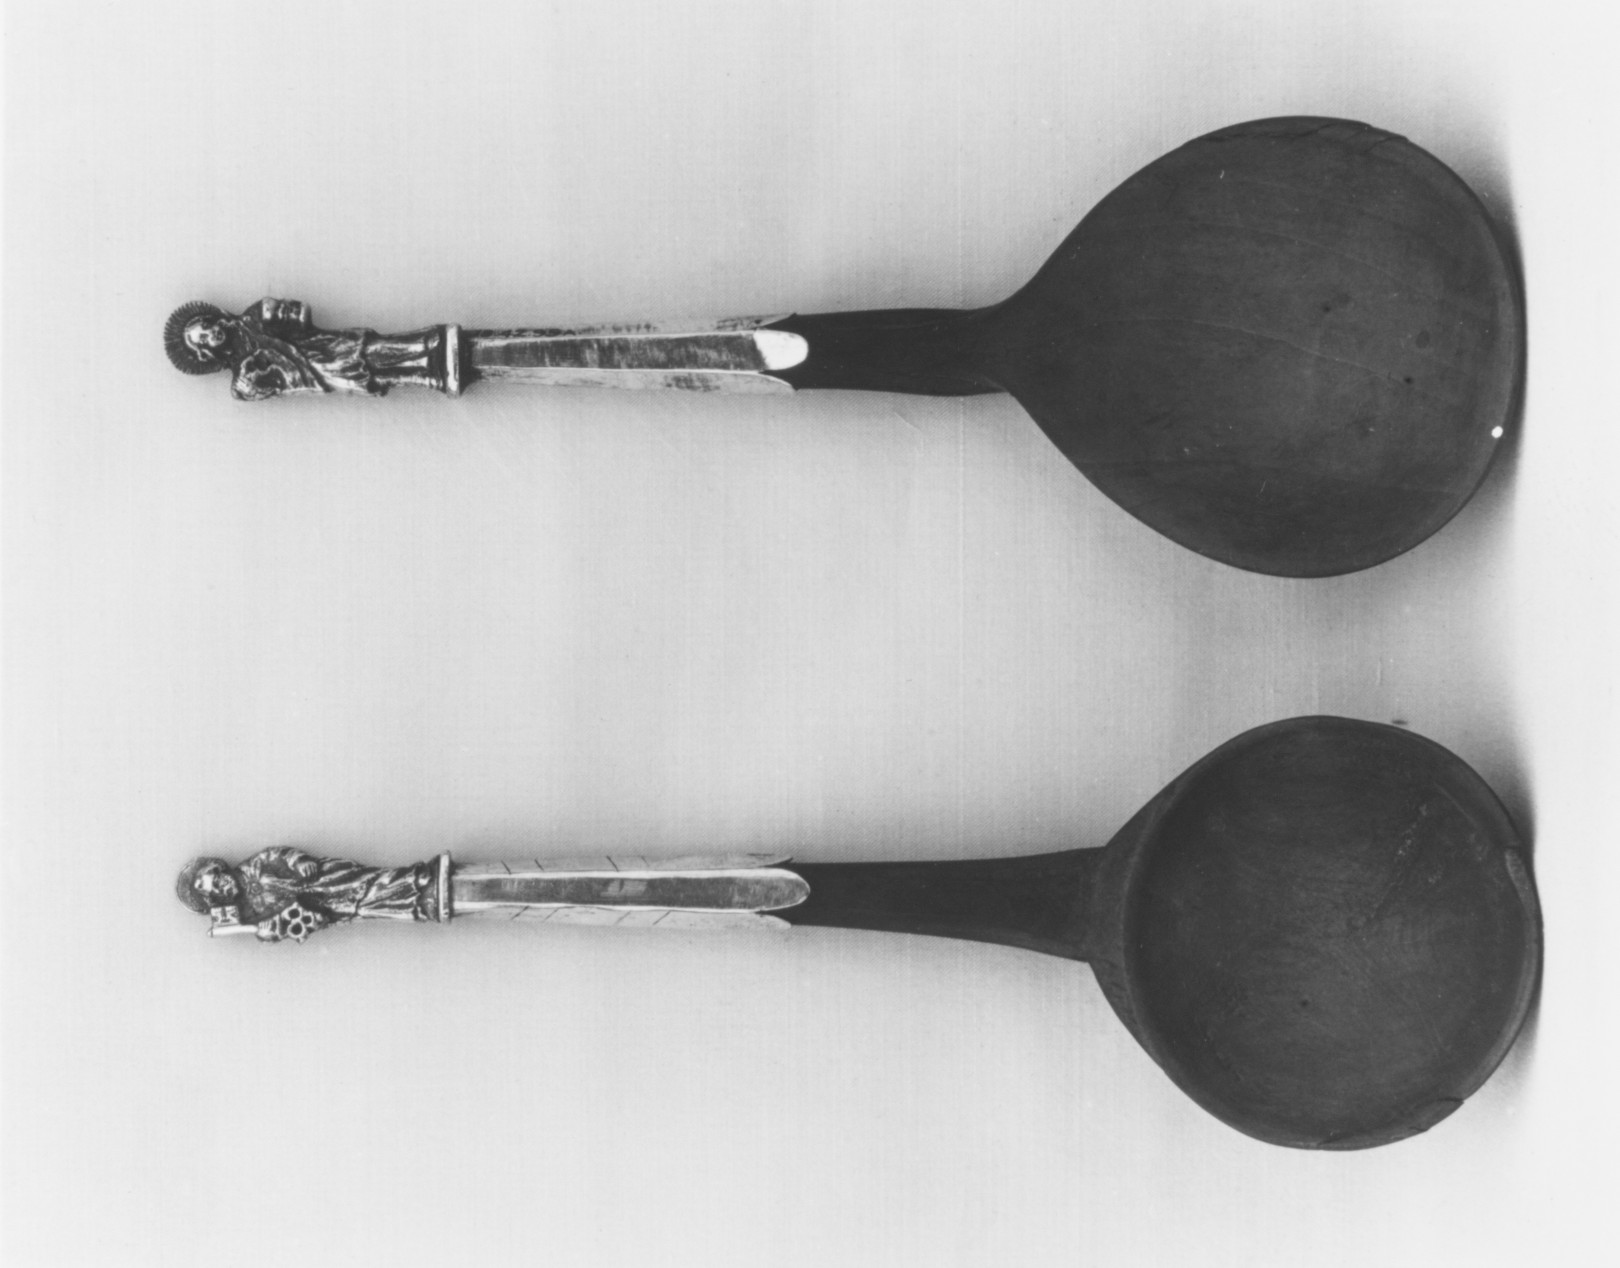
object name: apostle spoon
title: Two apostle spoons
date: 1600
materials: silver, wood